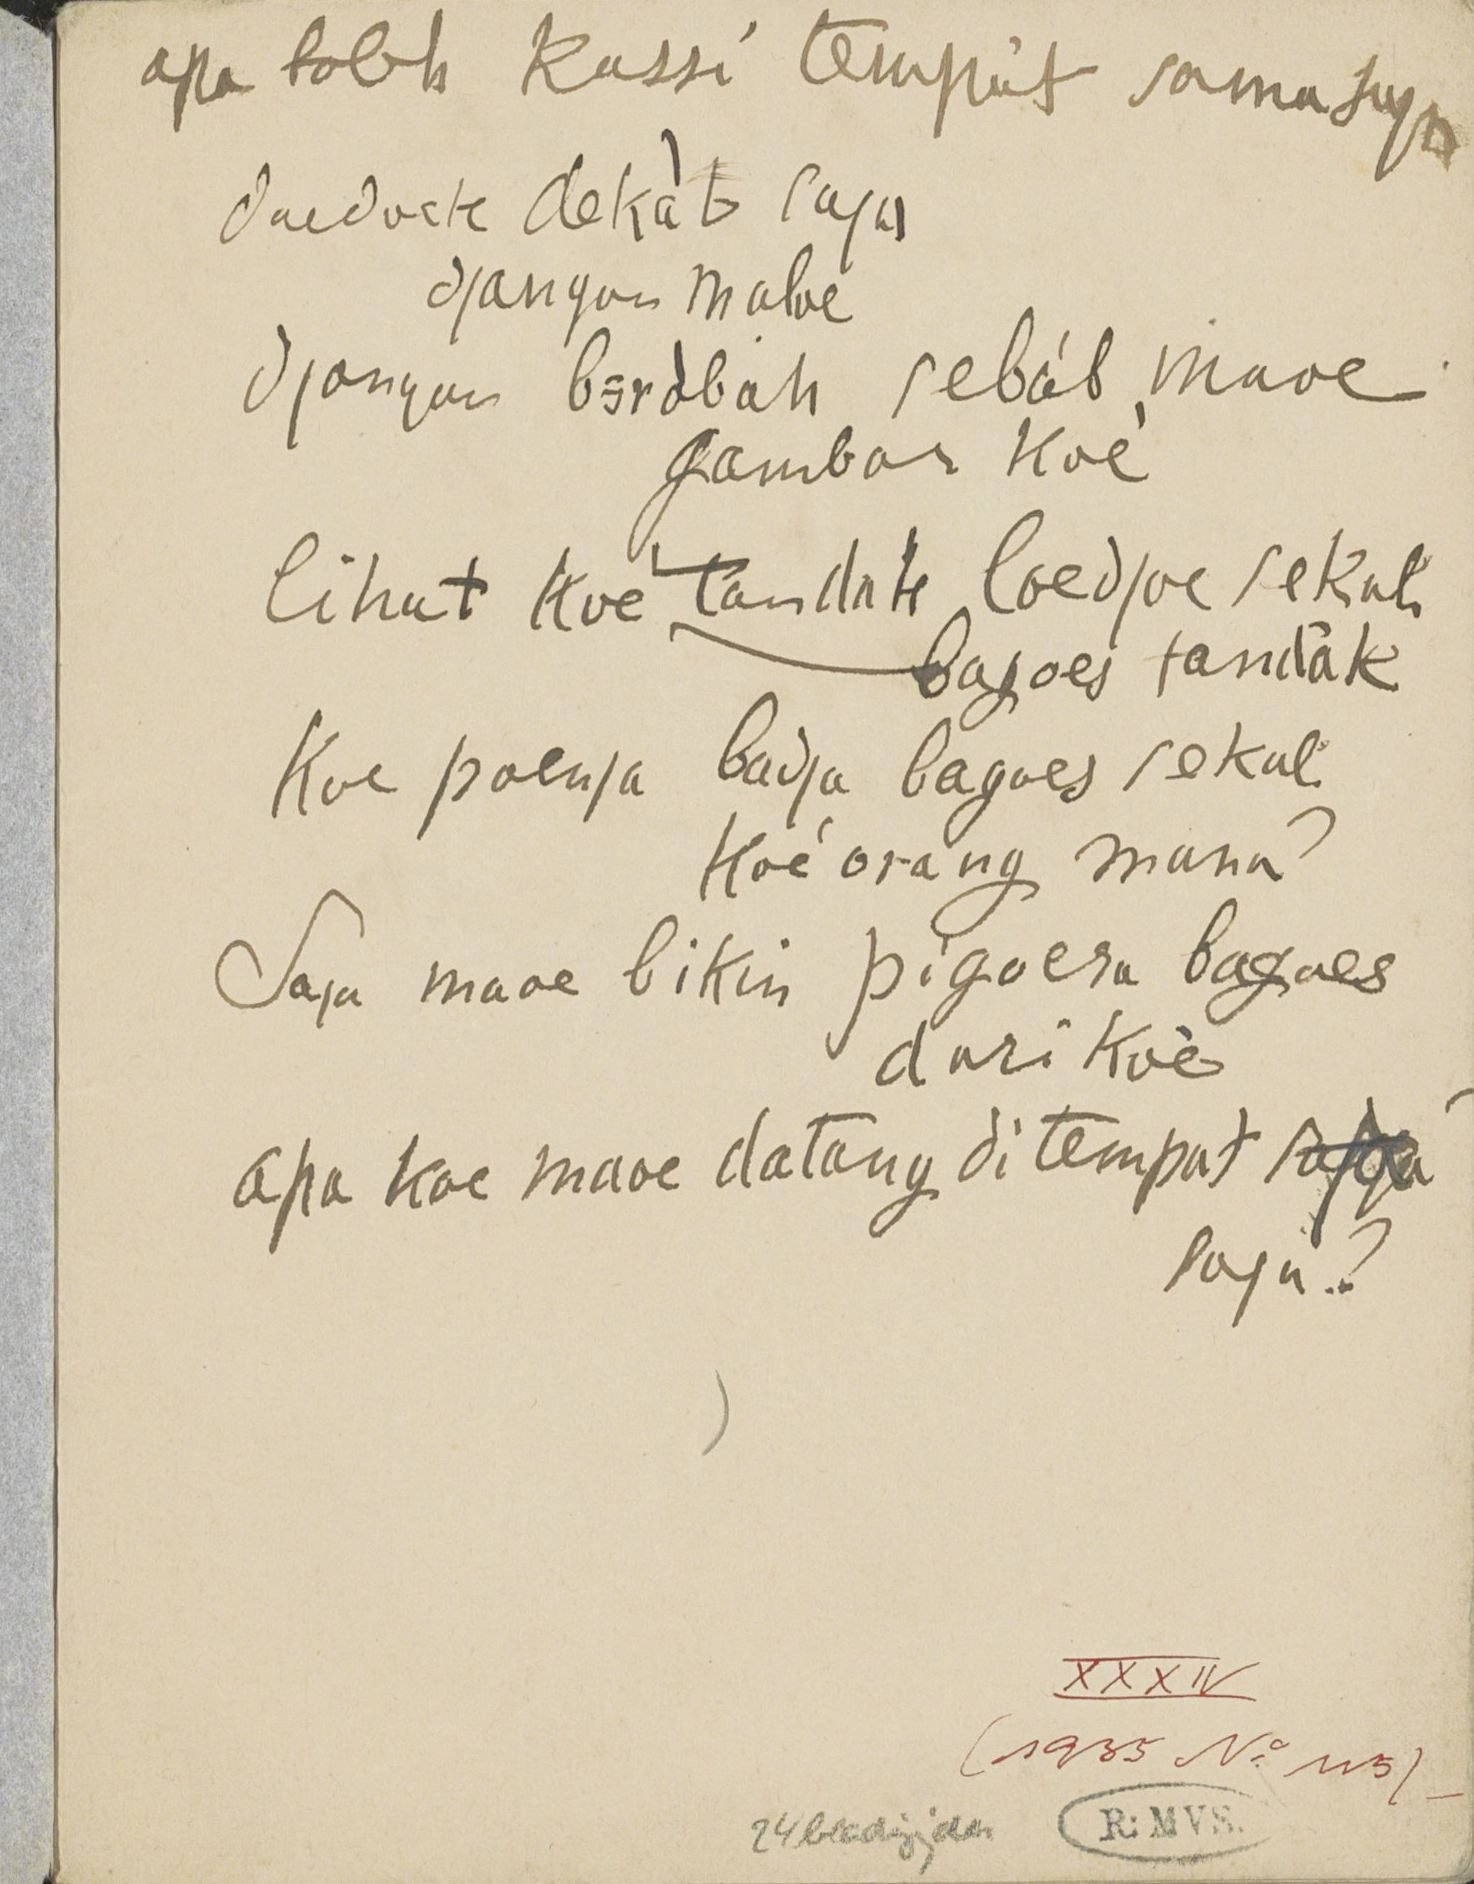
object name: sketchbook leaf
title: Annotaties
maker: isaac israels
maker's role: draughtsman, painter, print maker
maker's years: 1865-1934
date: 1921-1922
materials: ink, paper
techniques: pen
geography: dutch east indies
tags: dutch east indies, the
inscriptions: collector's mark: Lugt 2228, annotation: ‘[...]’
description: Pagina 1 uit schetsboek XXXIV met 24 pagina's.